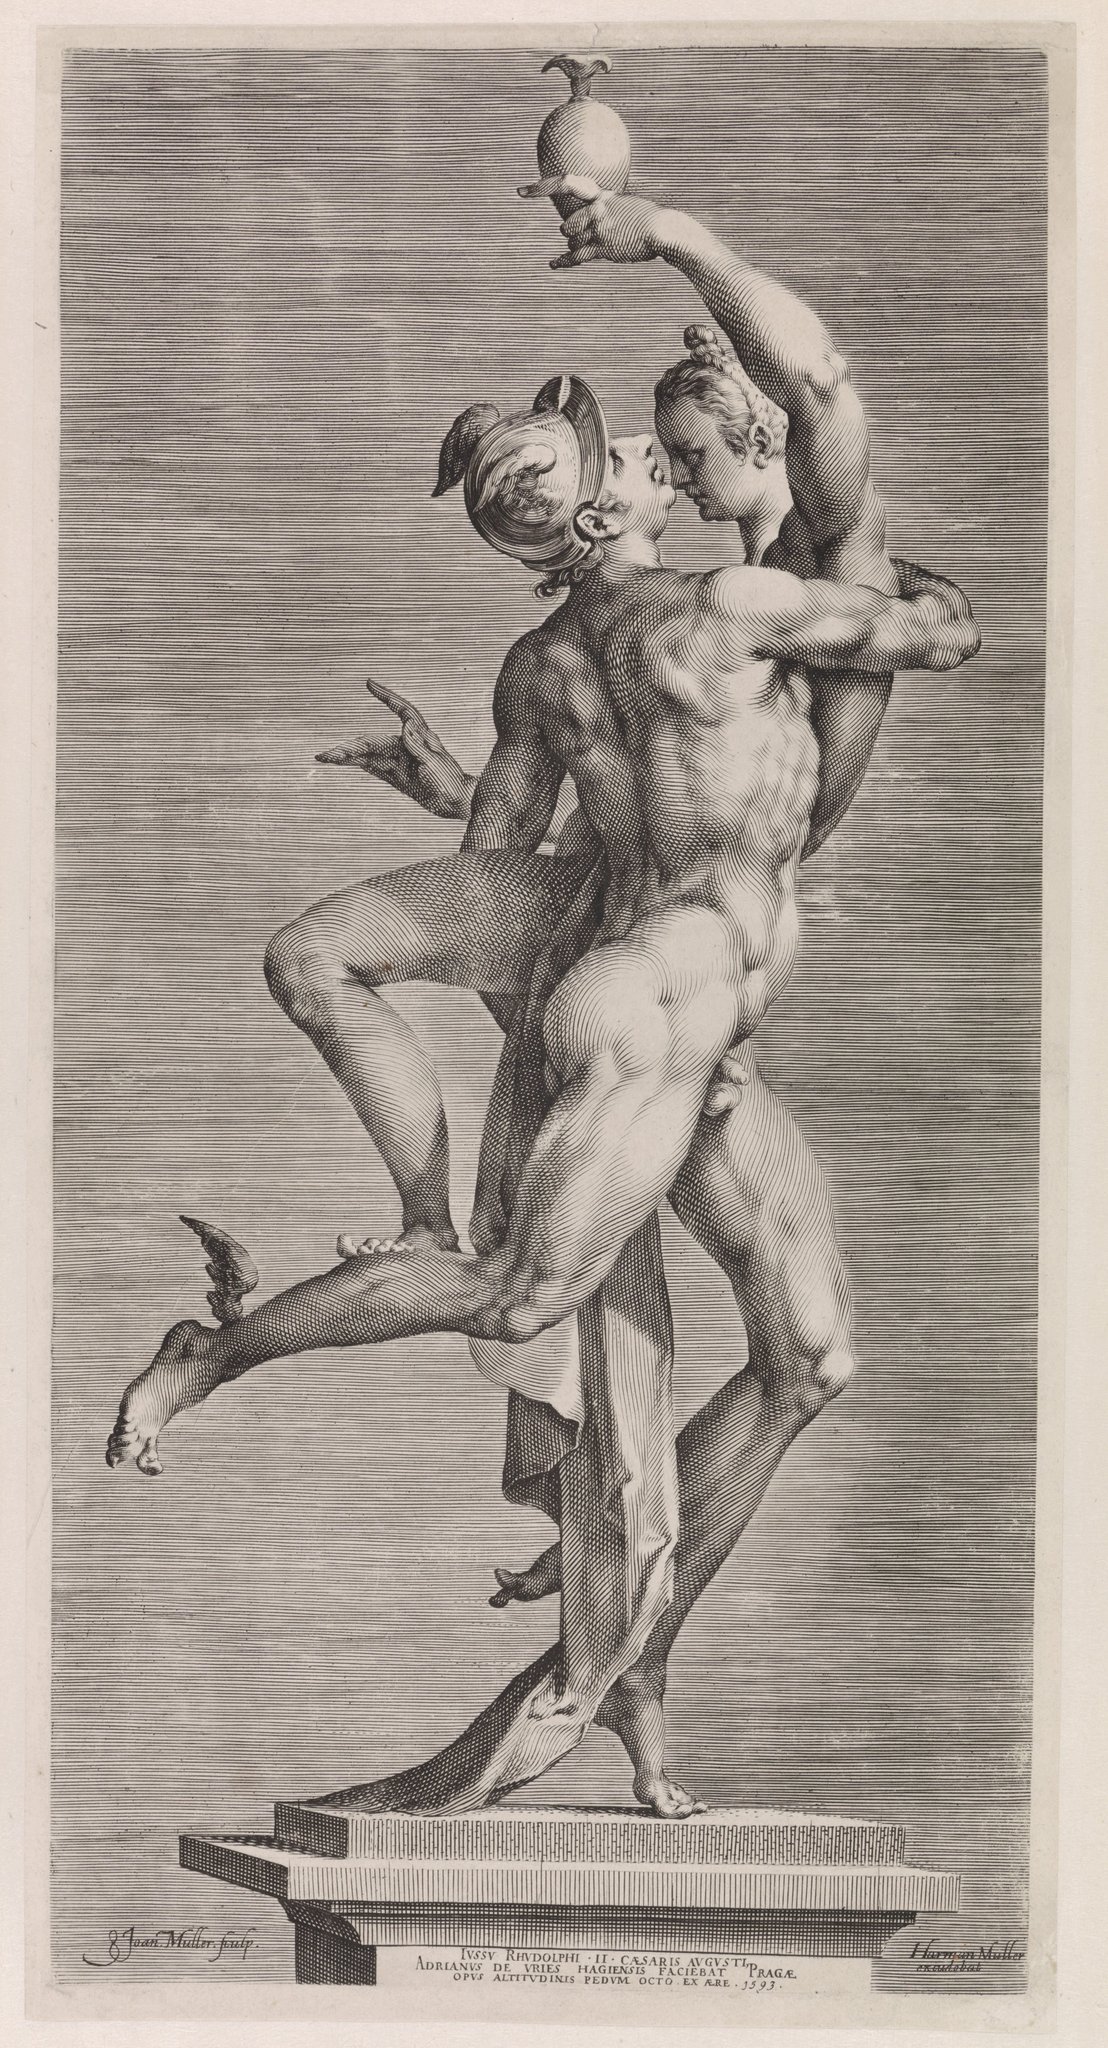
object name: print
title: Mercurius en Psyche: zijaanzicht met de zijde van Mercurius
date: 1595-1599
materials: paper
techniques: engraving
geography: amsterdam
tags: psyche is carried up to olympus by mercury, piece of sculpture, reproduction of a piece of sculpture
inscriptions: collector's mark: Lugt 240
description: Mercurius draagt Psyche naar de hemel. Naar een sculptuur van beeldhouwer Adriaen de Vries. Zijaanzicht met de zijde van Mercurius.